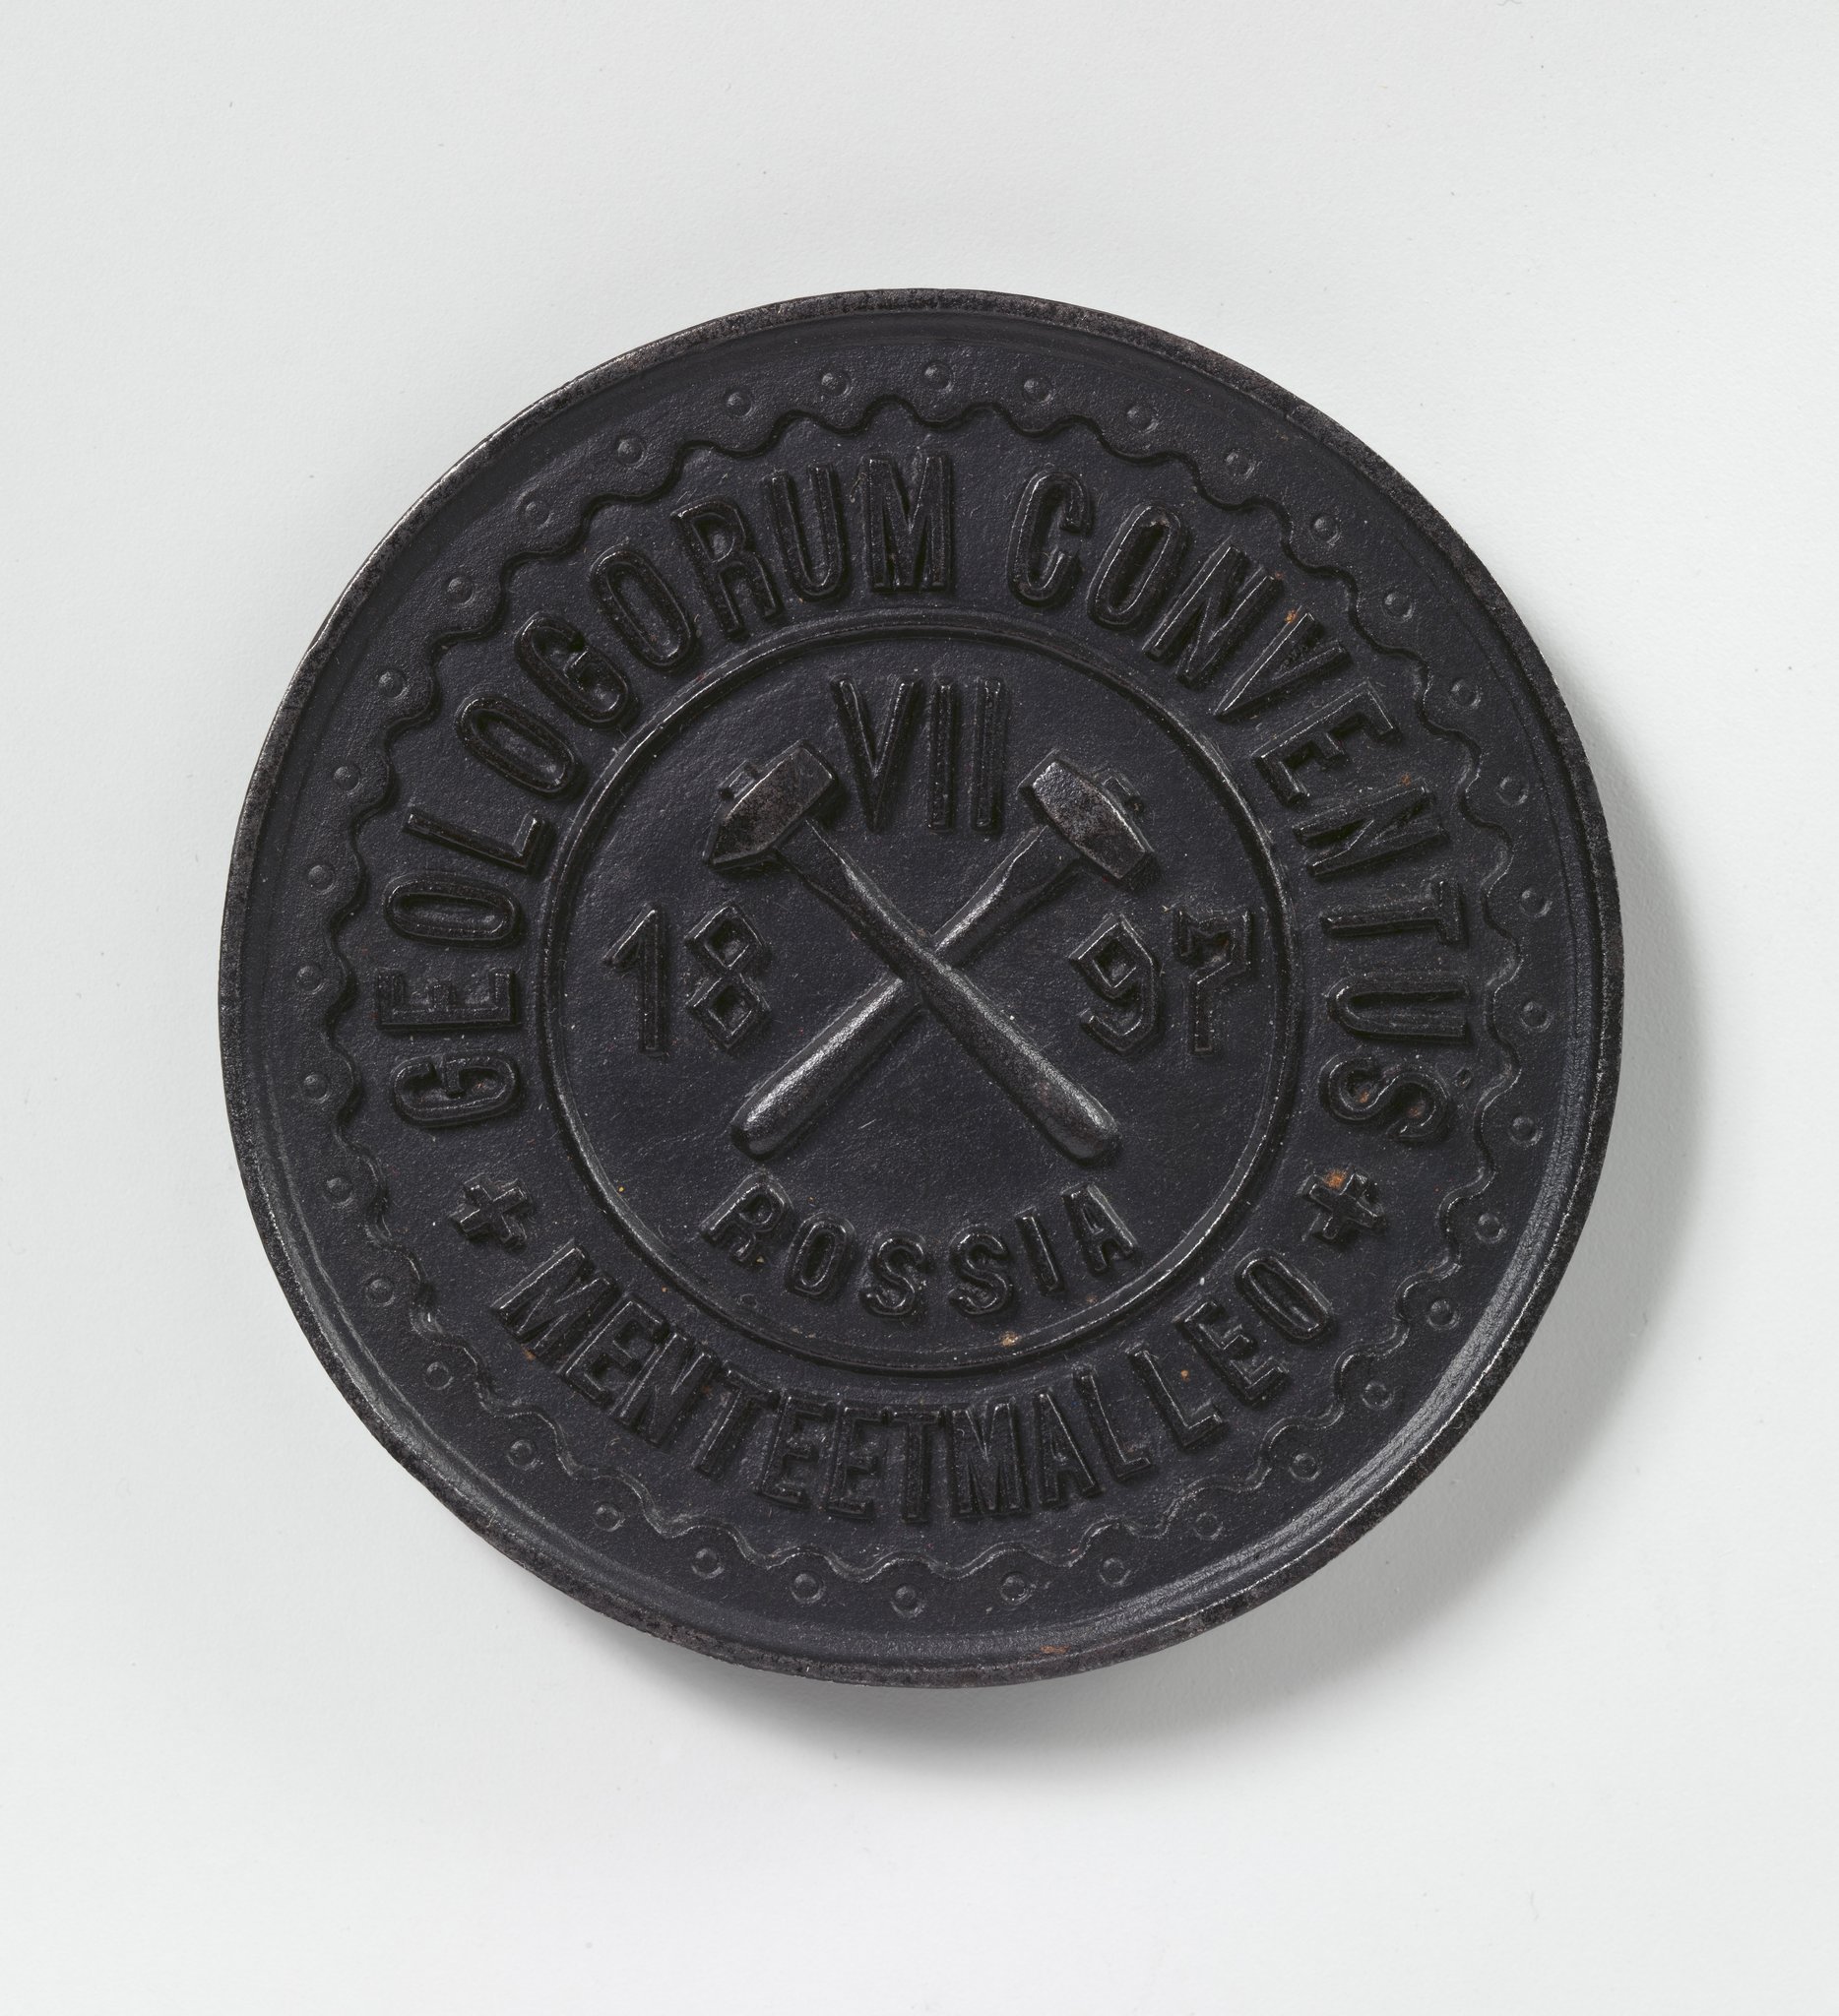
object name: medal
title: Medal for the Seventh Russian Mining Congress, Kychtym Mountainous District, 1897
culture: russian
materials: iron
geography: russia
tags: fish,hammers